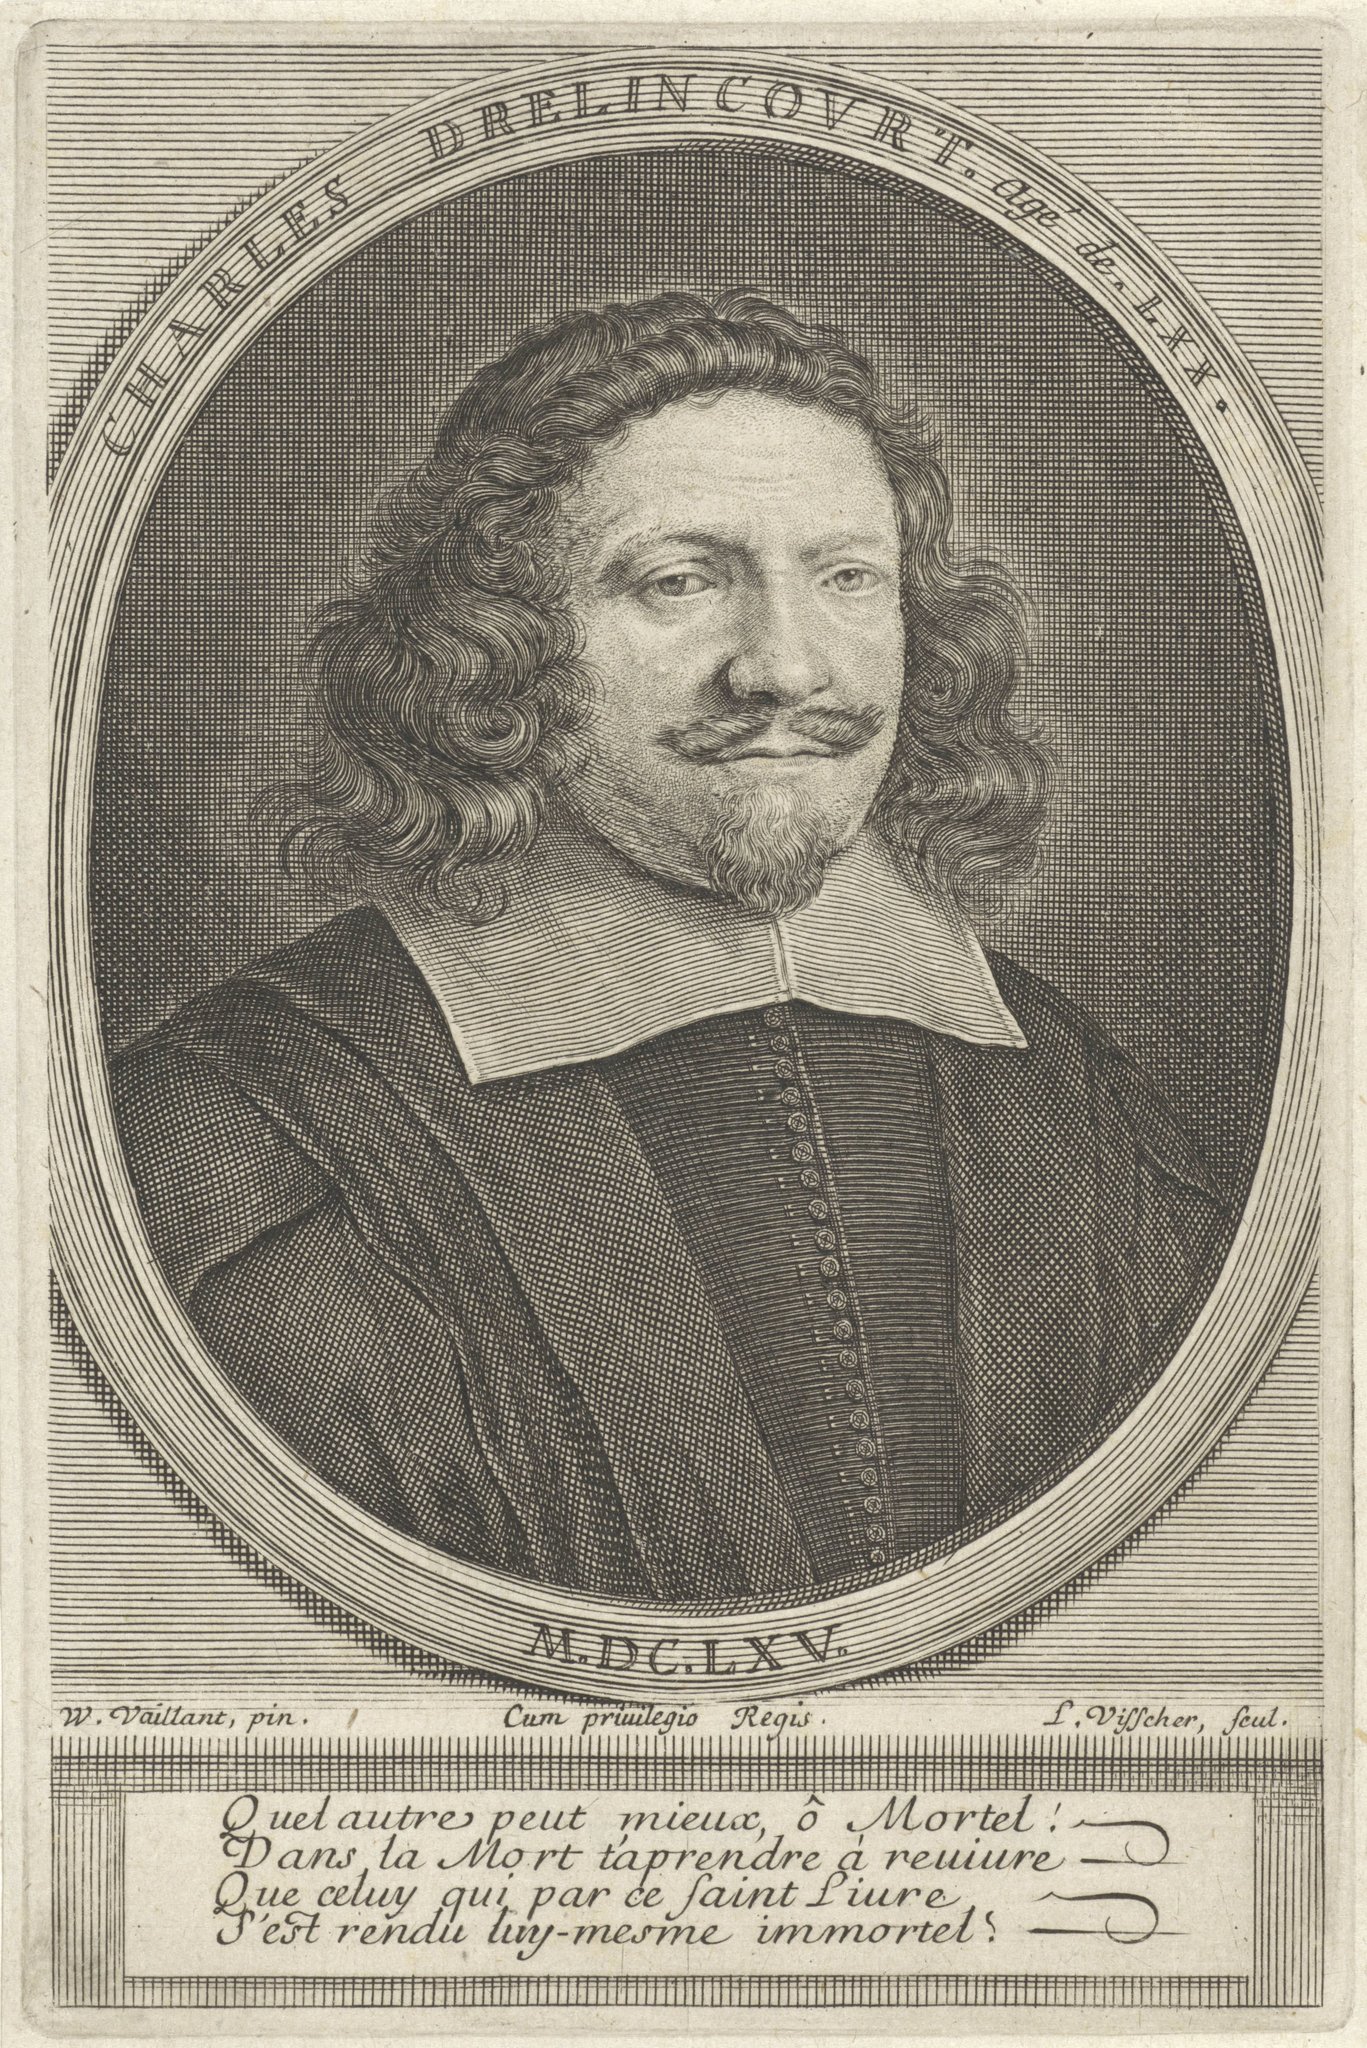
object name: print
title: Portret van Charles Drelincourt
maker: lambert visscher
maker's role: draughtsman, print maker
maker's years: 1640-1679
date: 1643-1691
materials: paper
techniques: engraving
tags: theoloog, charles drelincourt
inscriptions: collector's mark: Lugt 2228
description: De Franse theoloog Charles Drelincourt op 70-jarige leeftijd. Hij is gekleed in een toga met brede platte kraag. Op de stenen sokkel waarop het portret rust staat een vers in het Latijn.